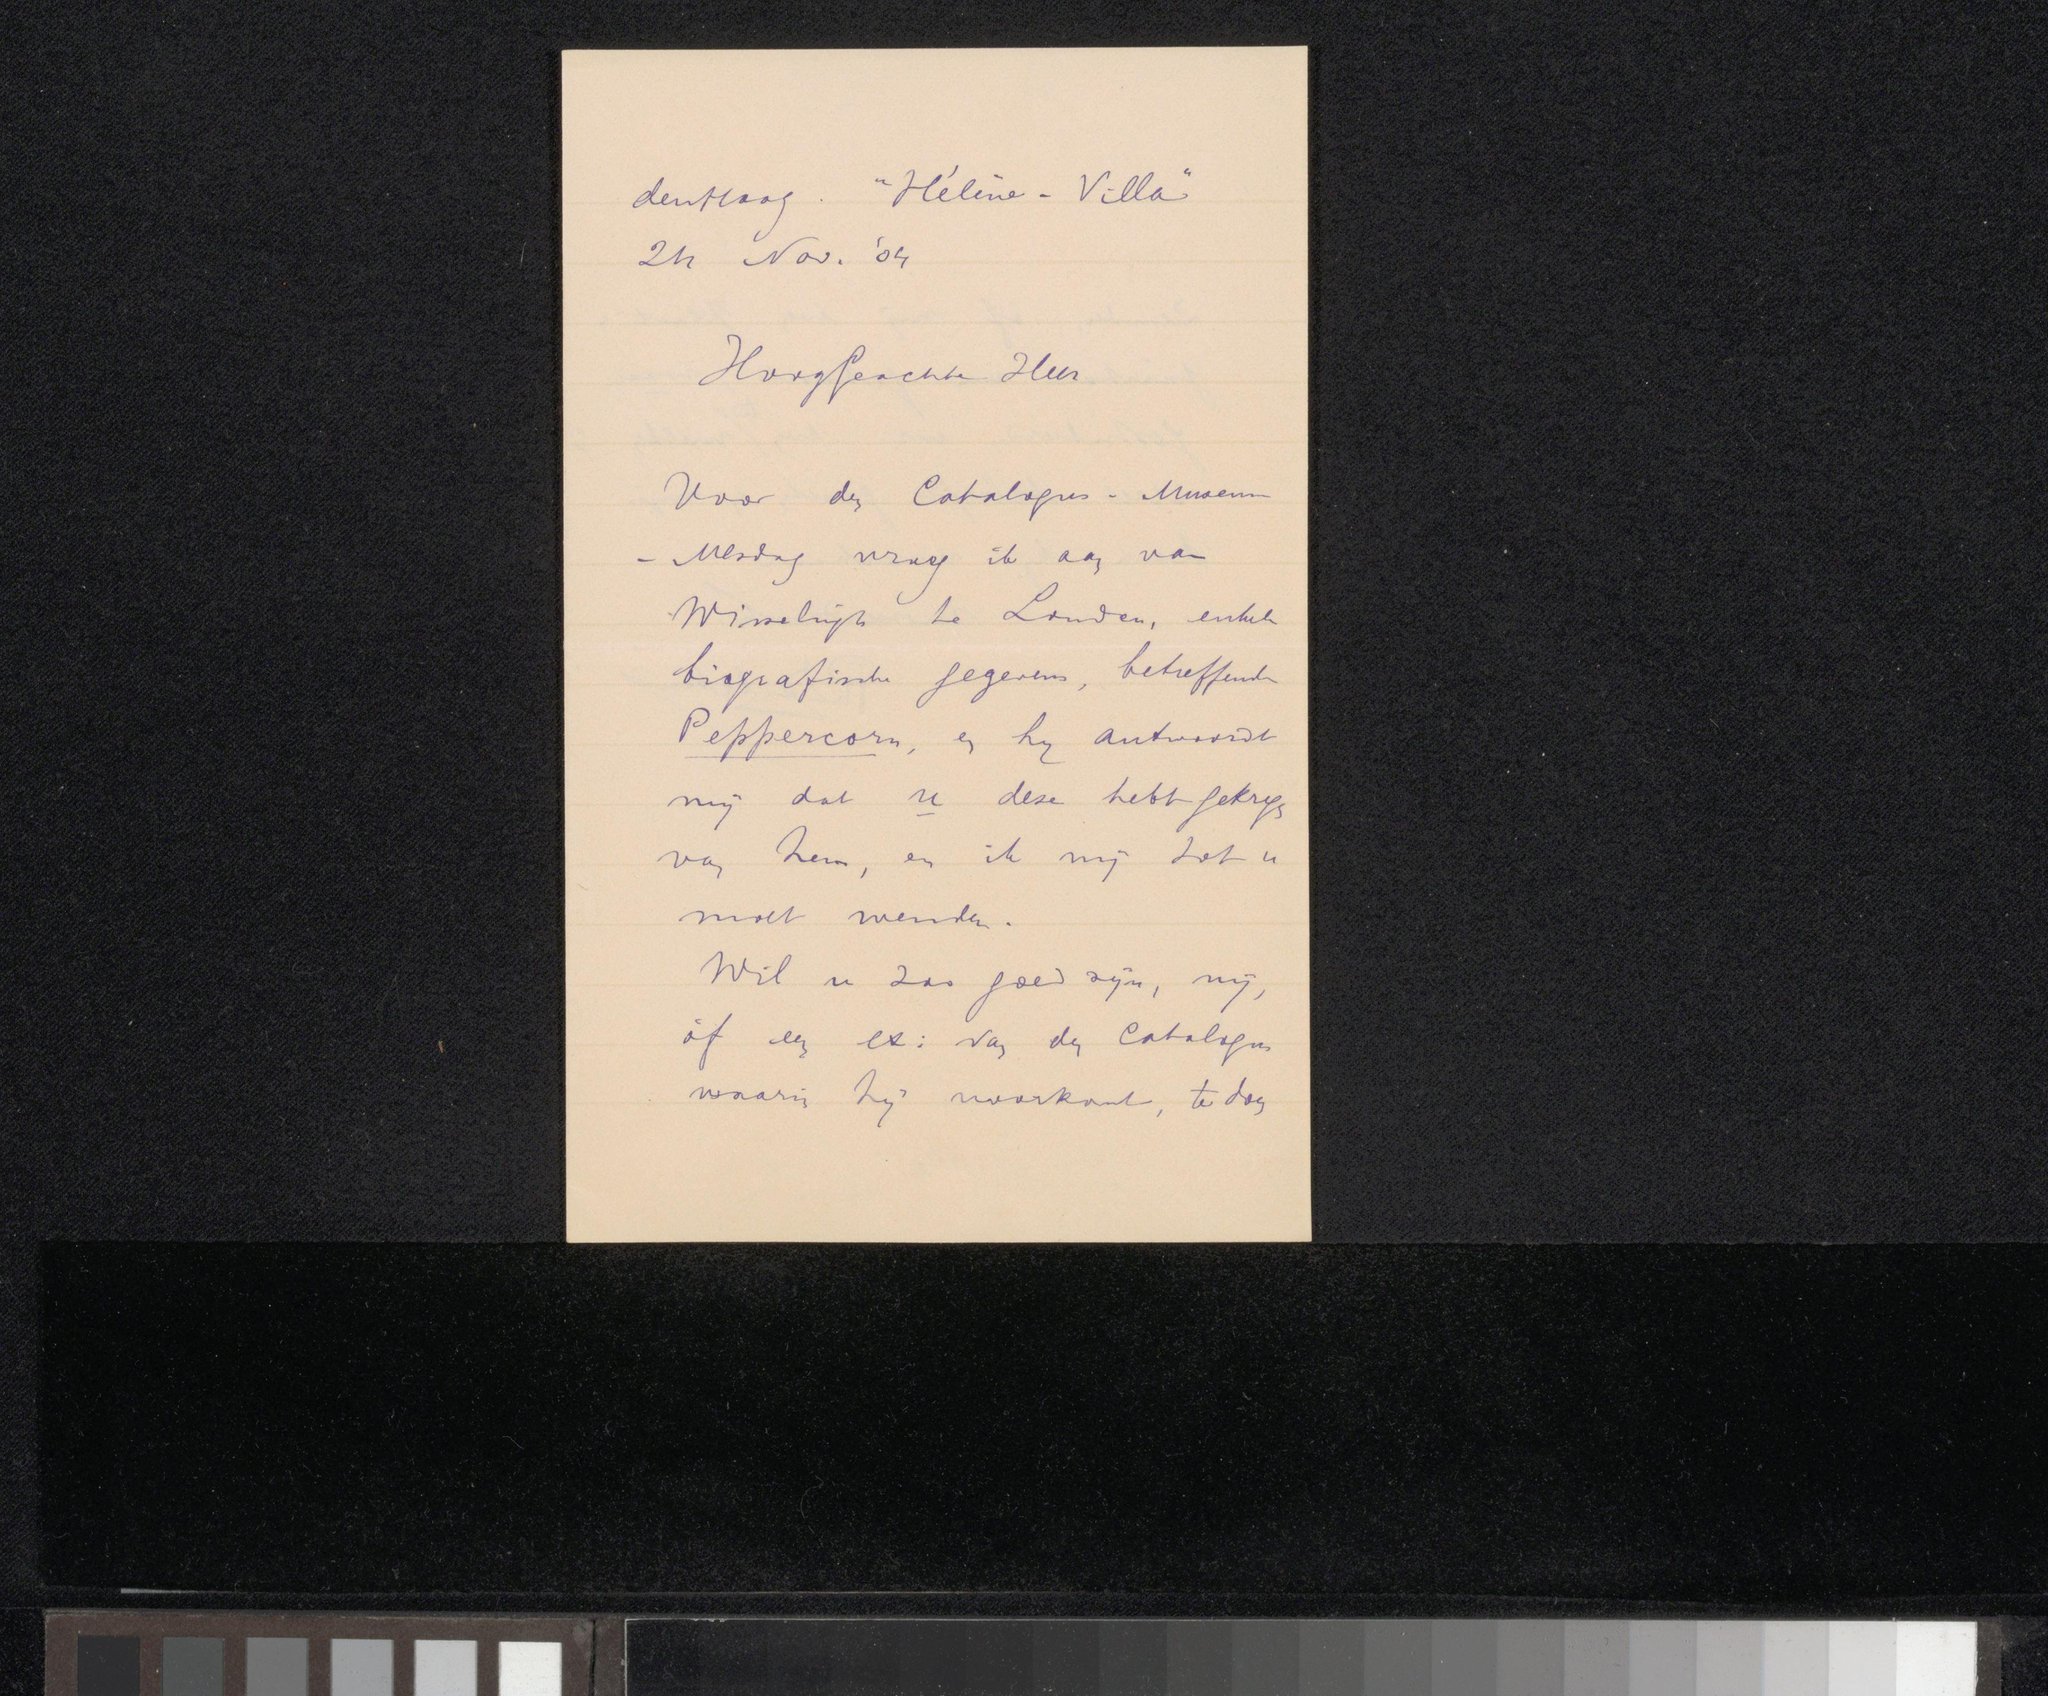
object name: letter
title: Brief aan anoniem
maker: philip zilcken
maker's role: draughtsman, painter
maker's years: 1857-1930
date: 1904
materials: ink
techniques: pen, writing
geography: the hague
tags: arthur douglas peppercorn, elbert jan van wisselingh